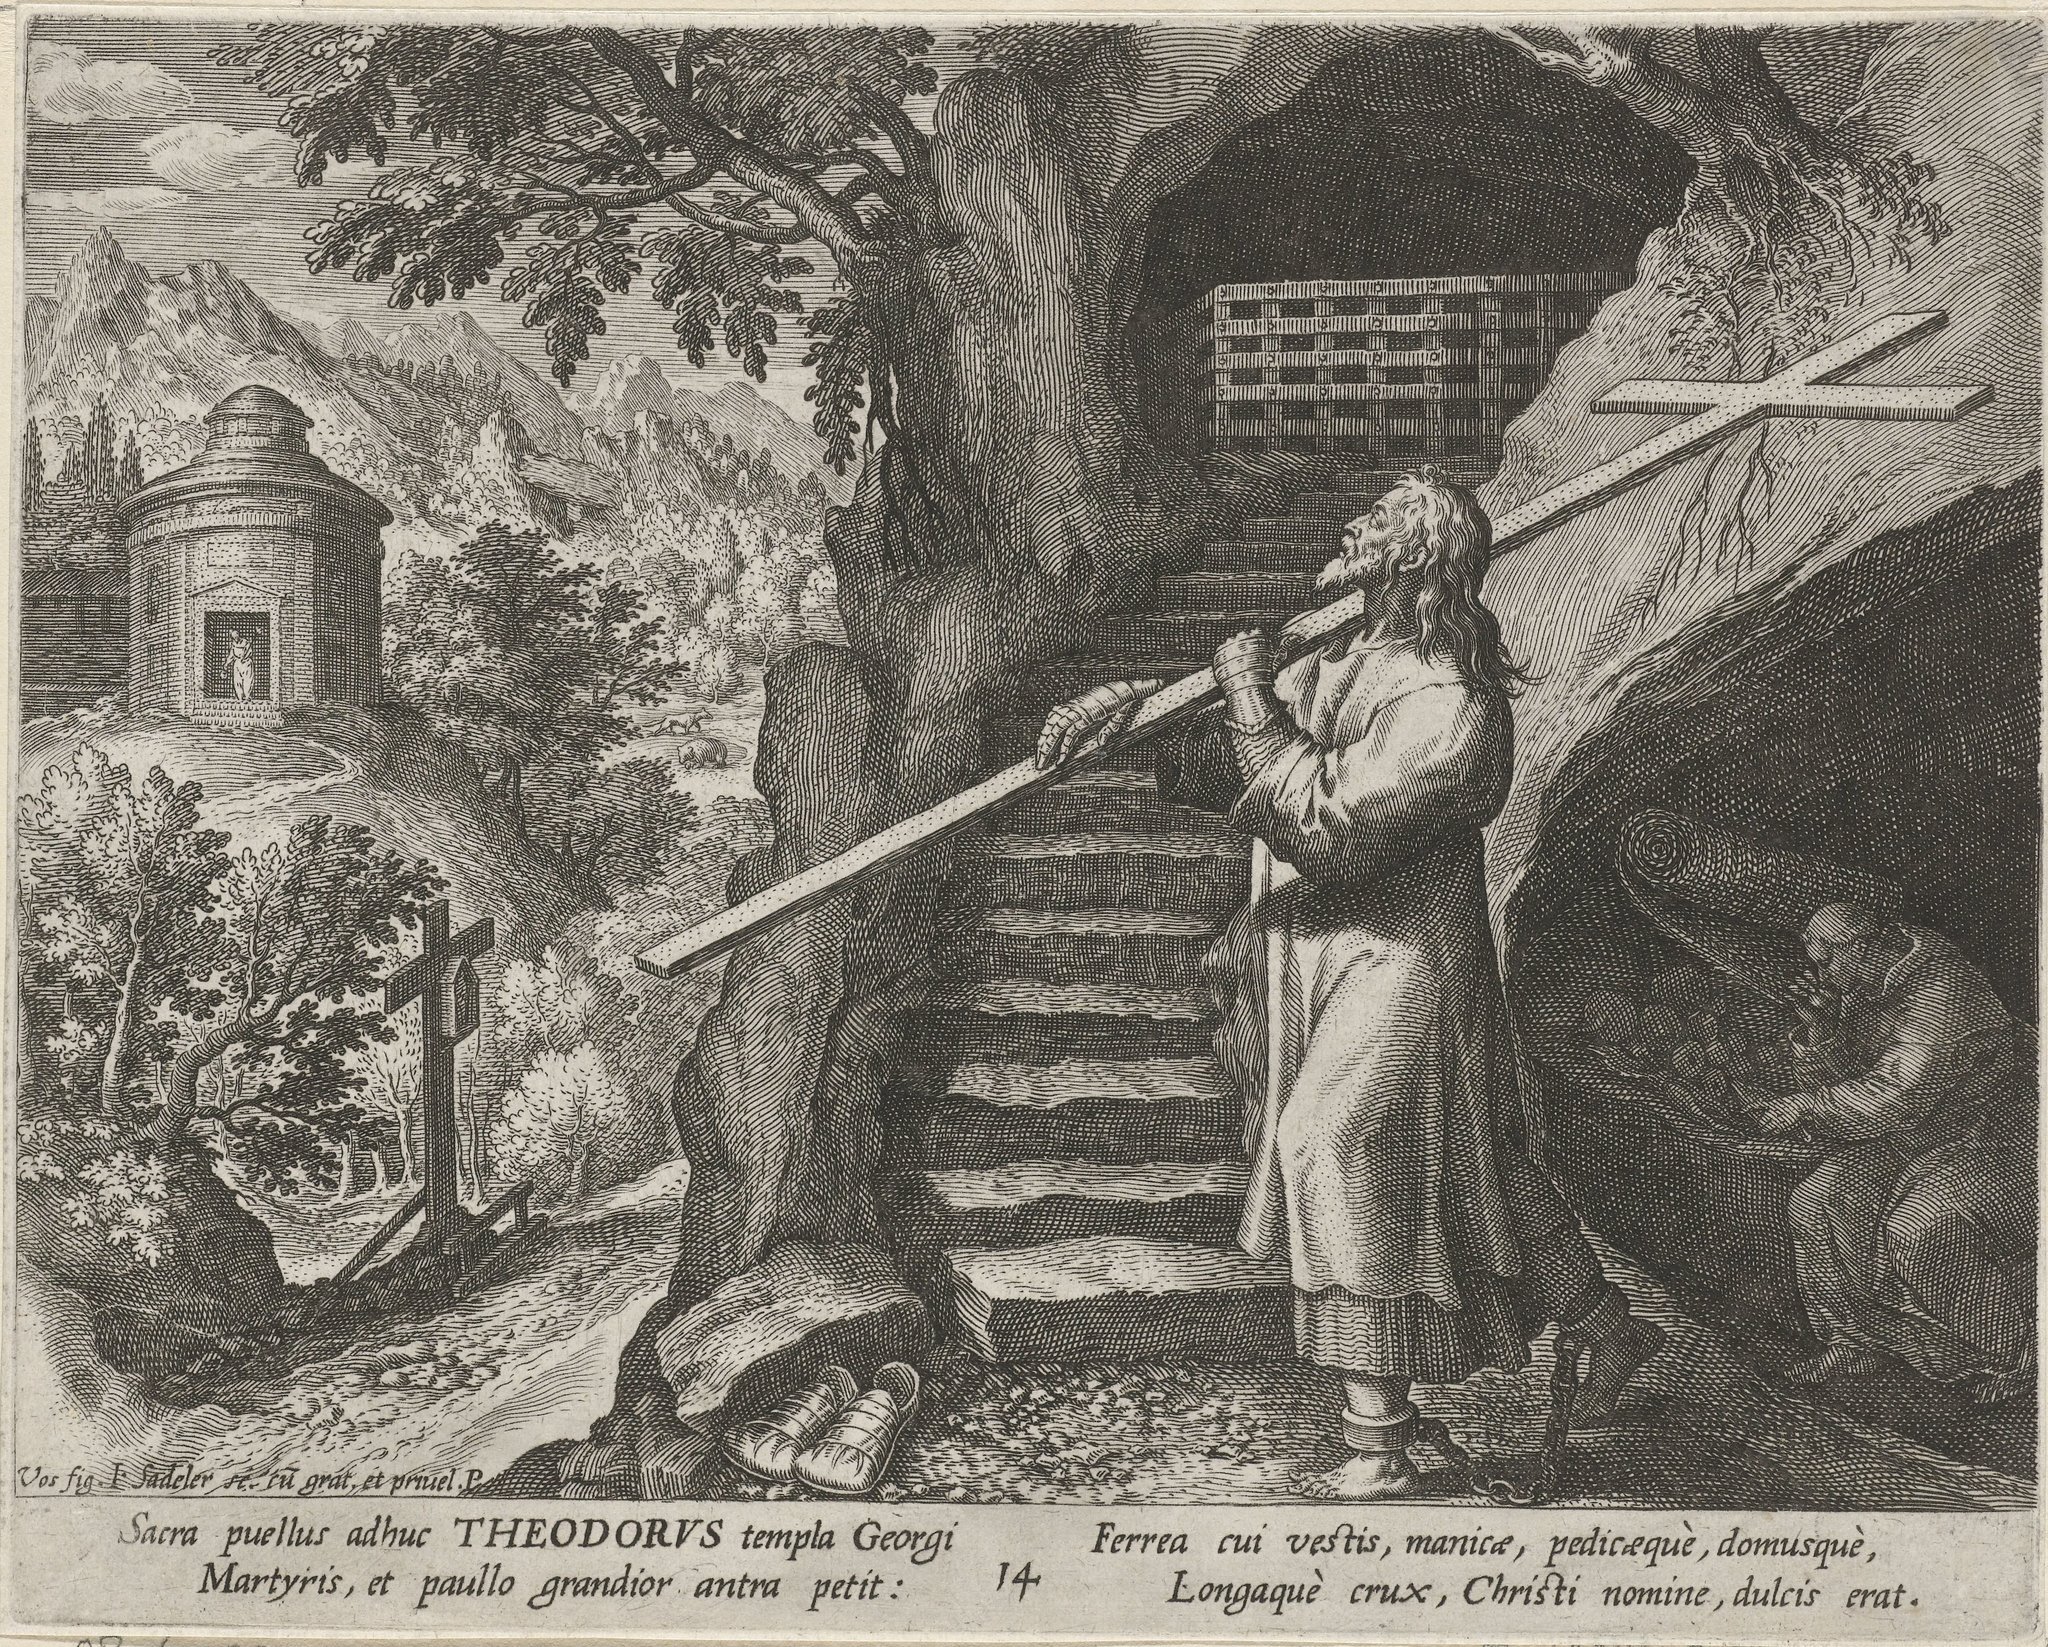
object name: print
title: Heilige Theodorus Tiro als kluizenaar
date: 1598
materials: paper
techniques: engraving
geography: venice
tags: male saints (with name), altarcross, crucifix, armour, anchorite, hermit, cave, grotto, temple, shrine ~ roman religion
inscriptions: collector's mark: Lugt 240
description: Op de voorgrond de H. Theodorus Tiro, een vroegchristelijke kluizenaar en Griekse soldatenheilige, in wapenuitrusting. Theodorus draagt een kruis en is geketend aan zijn voeten. Hij verlaat een grot. Op de achtergrond een Romeinse tempel.